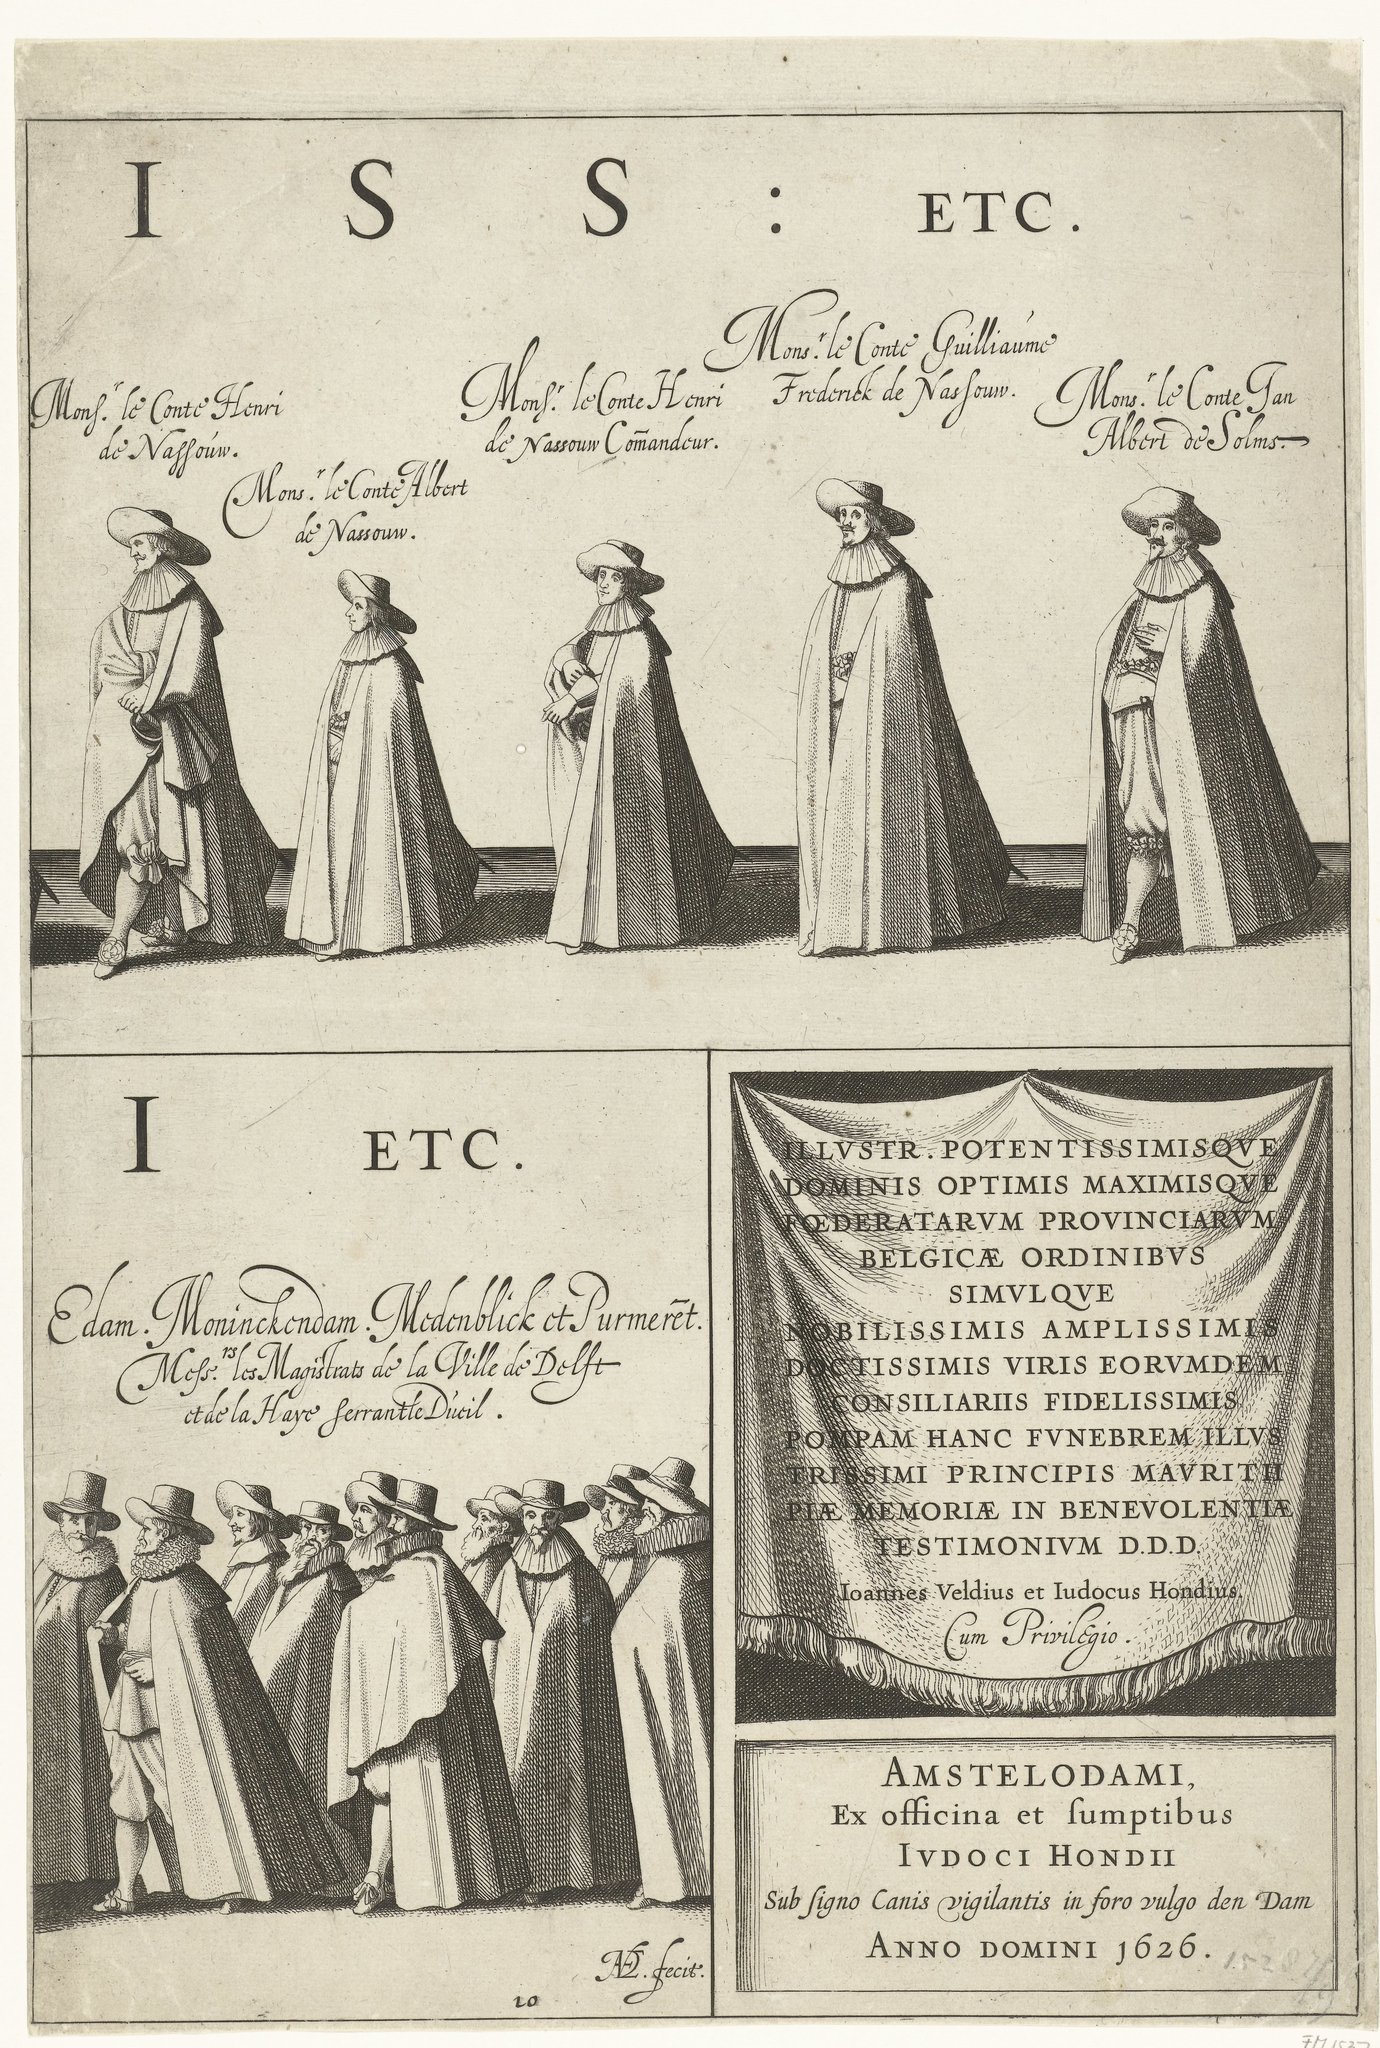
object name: print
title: Haec pompa funebris spectata fuit delphis Batavorum decimo sexto septembris anno 1625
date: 1626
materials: paper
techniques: etching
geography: northern netherlands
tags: the hague, maurice (prince of orange), cortege, funeral procession, delft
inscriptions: date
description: De begrafenisstoet van prins Maurits te Delft op 16 september 1625 (plaat 10 en eind). Plaat verdeeld in twee voorstellingen. Boven: deel van de stoet met deelnemers. Onder drie voorstellingen: deel van de stoet met deelnemers, doek met opdracht en cartouche met adres. Met de namen van de afgebeelde personen.